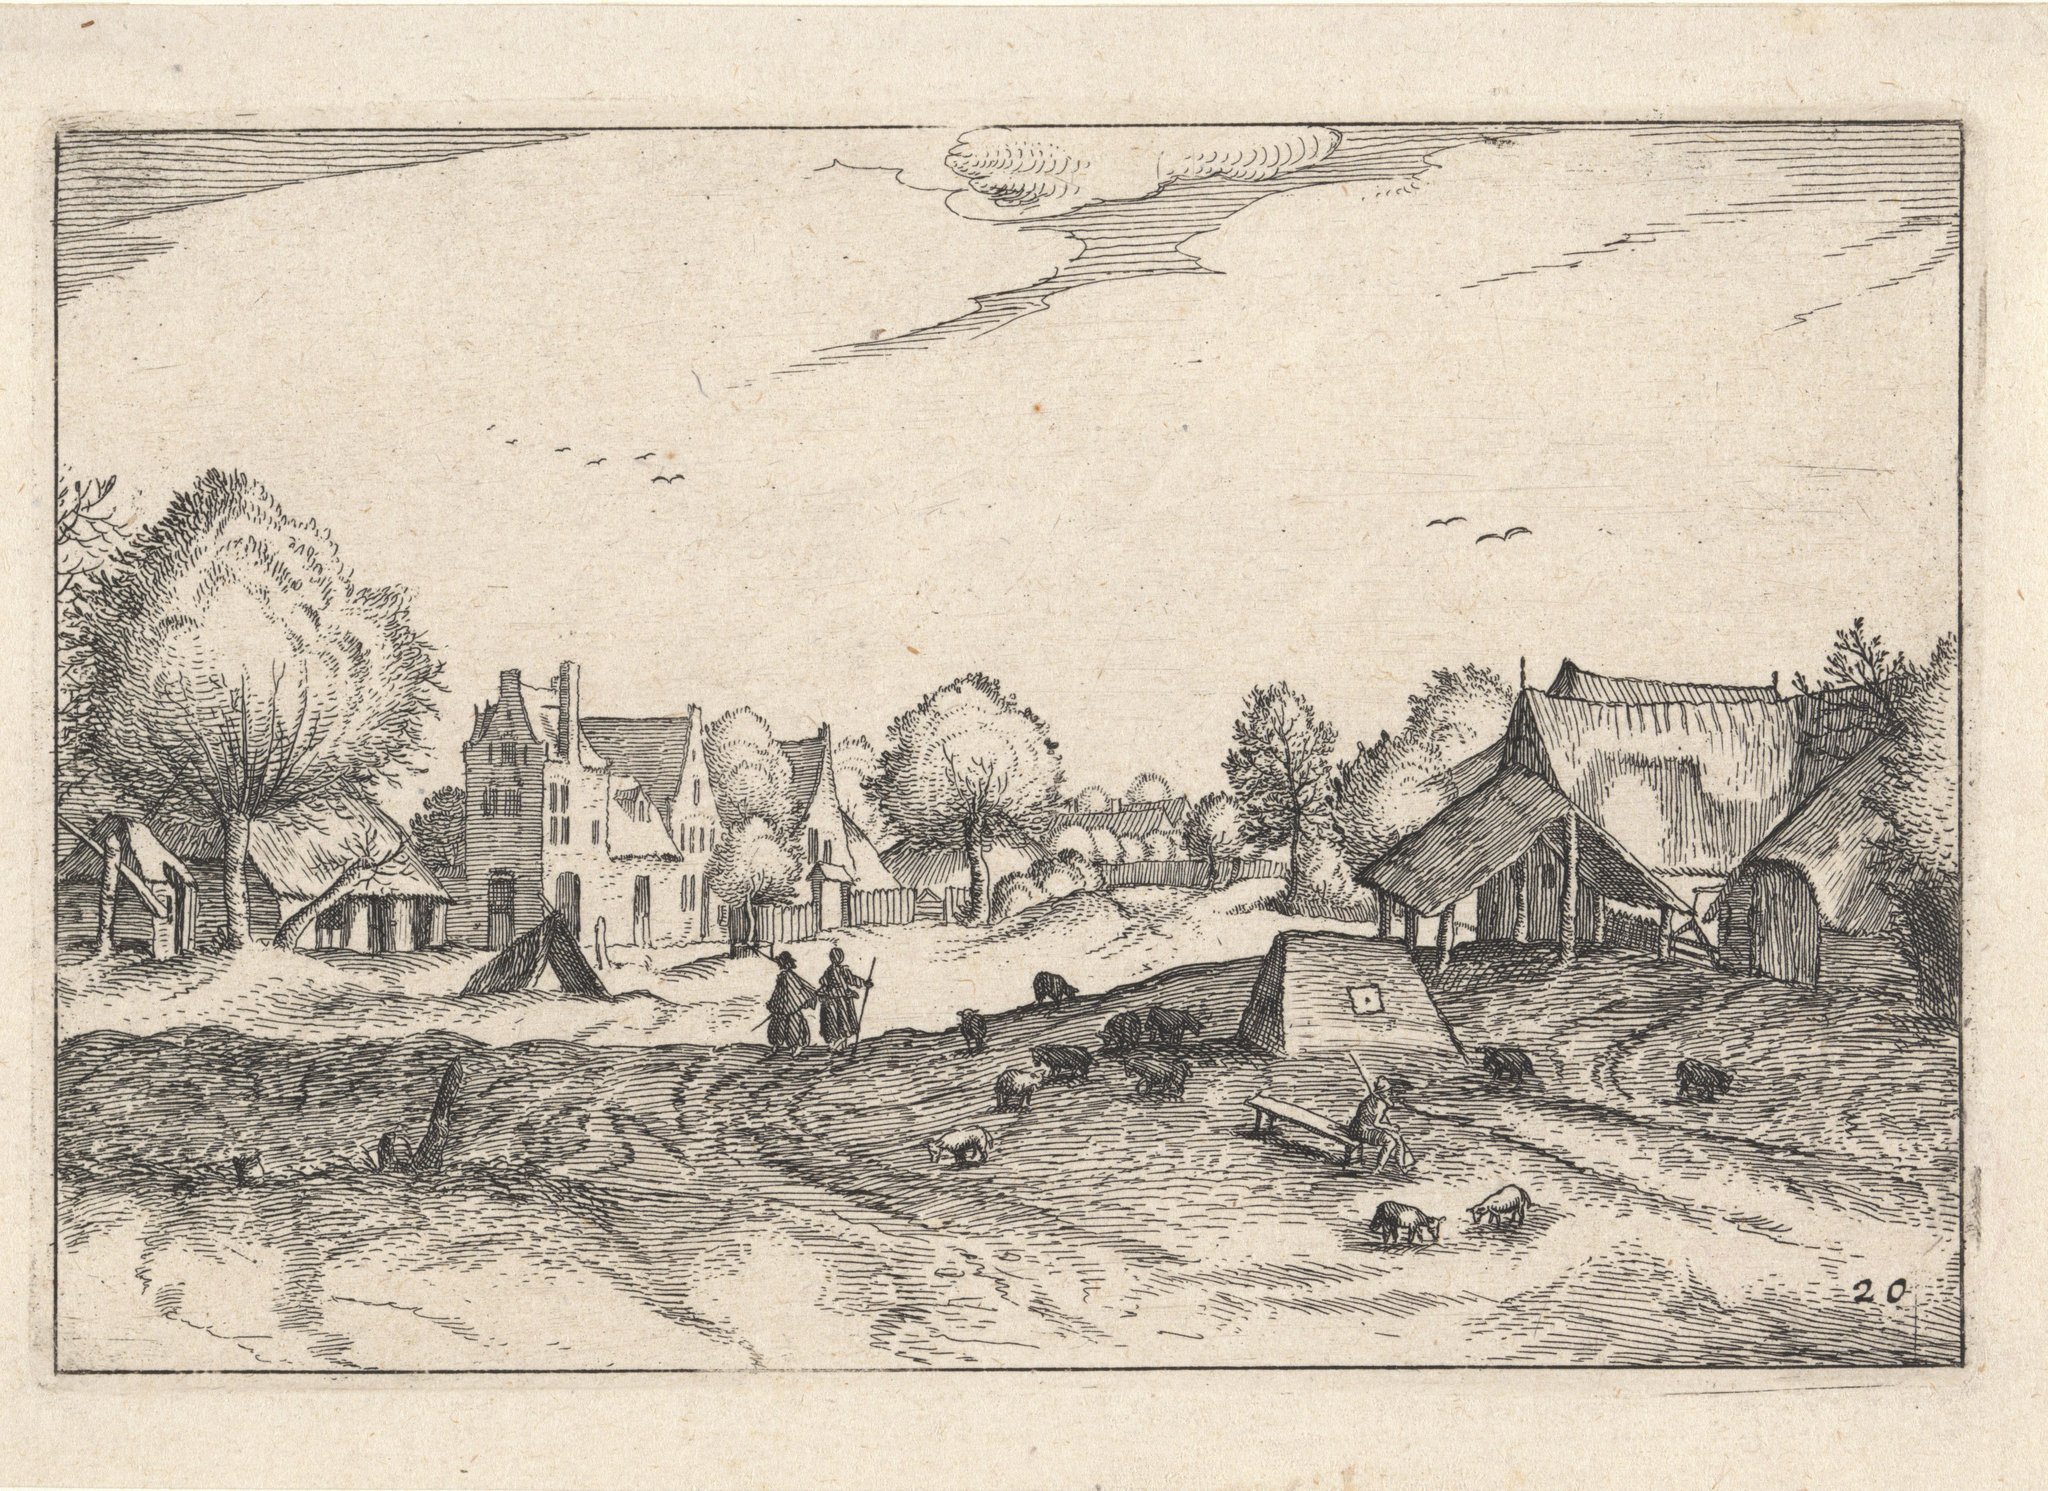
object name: print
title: Dorp in een landschap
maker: claes jansz. visscher (ii)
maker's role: draughtsman, print maker, publisher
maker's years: 1586-1652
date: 1620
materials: paper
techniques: etching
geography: amsterdam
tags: herding, herdsman, herdswoman, shepherd, shepherdess, cowherd, etc., village street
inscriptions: collector's mark: Lugt 240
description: Gezicht op een glooiend landschap met een dorp waar een weg doorheen voert. Op de voorgrond zit een herder met zijn kudde.